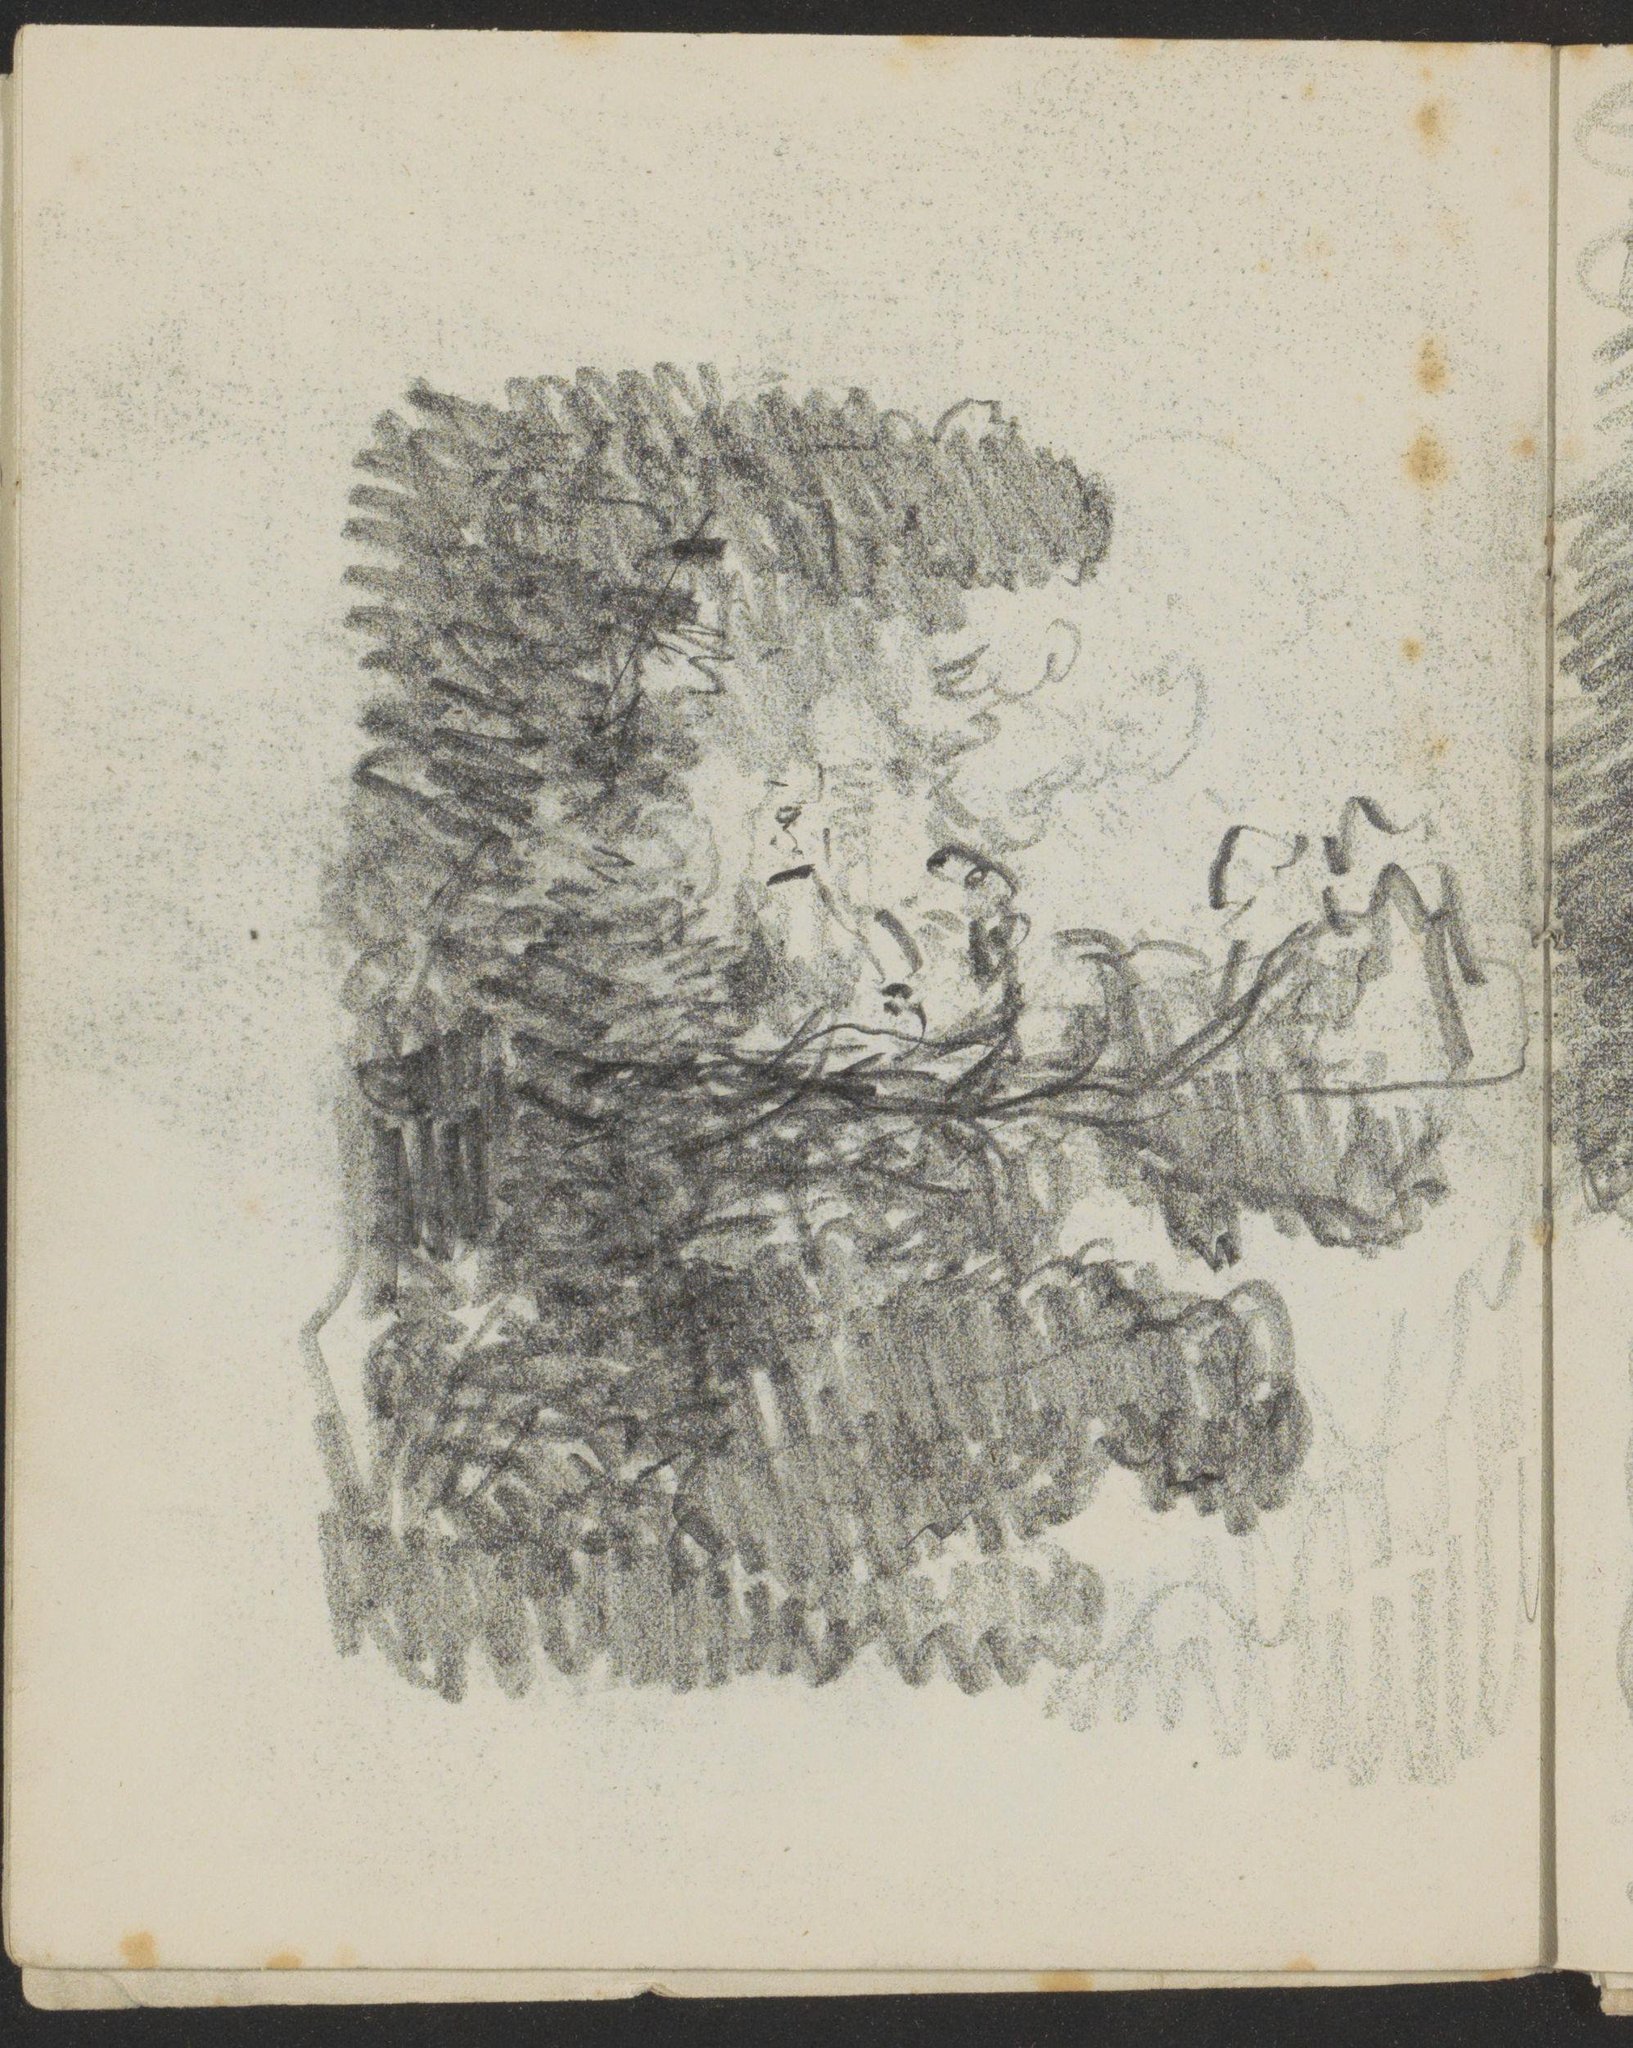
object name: sketchbook leaf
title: Bomen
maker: maria vos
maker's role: draughtsman, painter, print maker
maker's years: 1824-1906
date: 1834-1906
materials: paper, pencil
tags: trees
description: Blad 8 verso uit een schetsboek met 17 bladen.